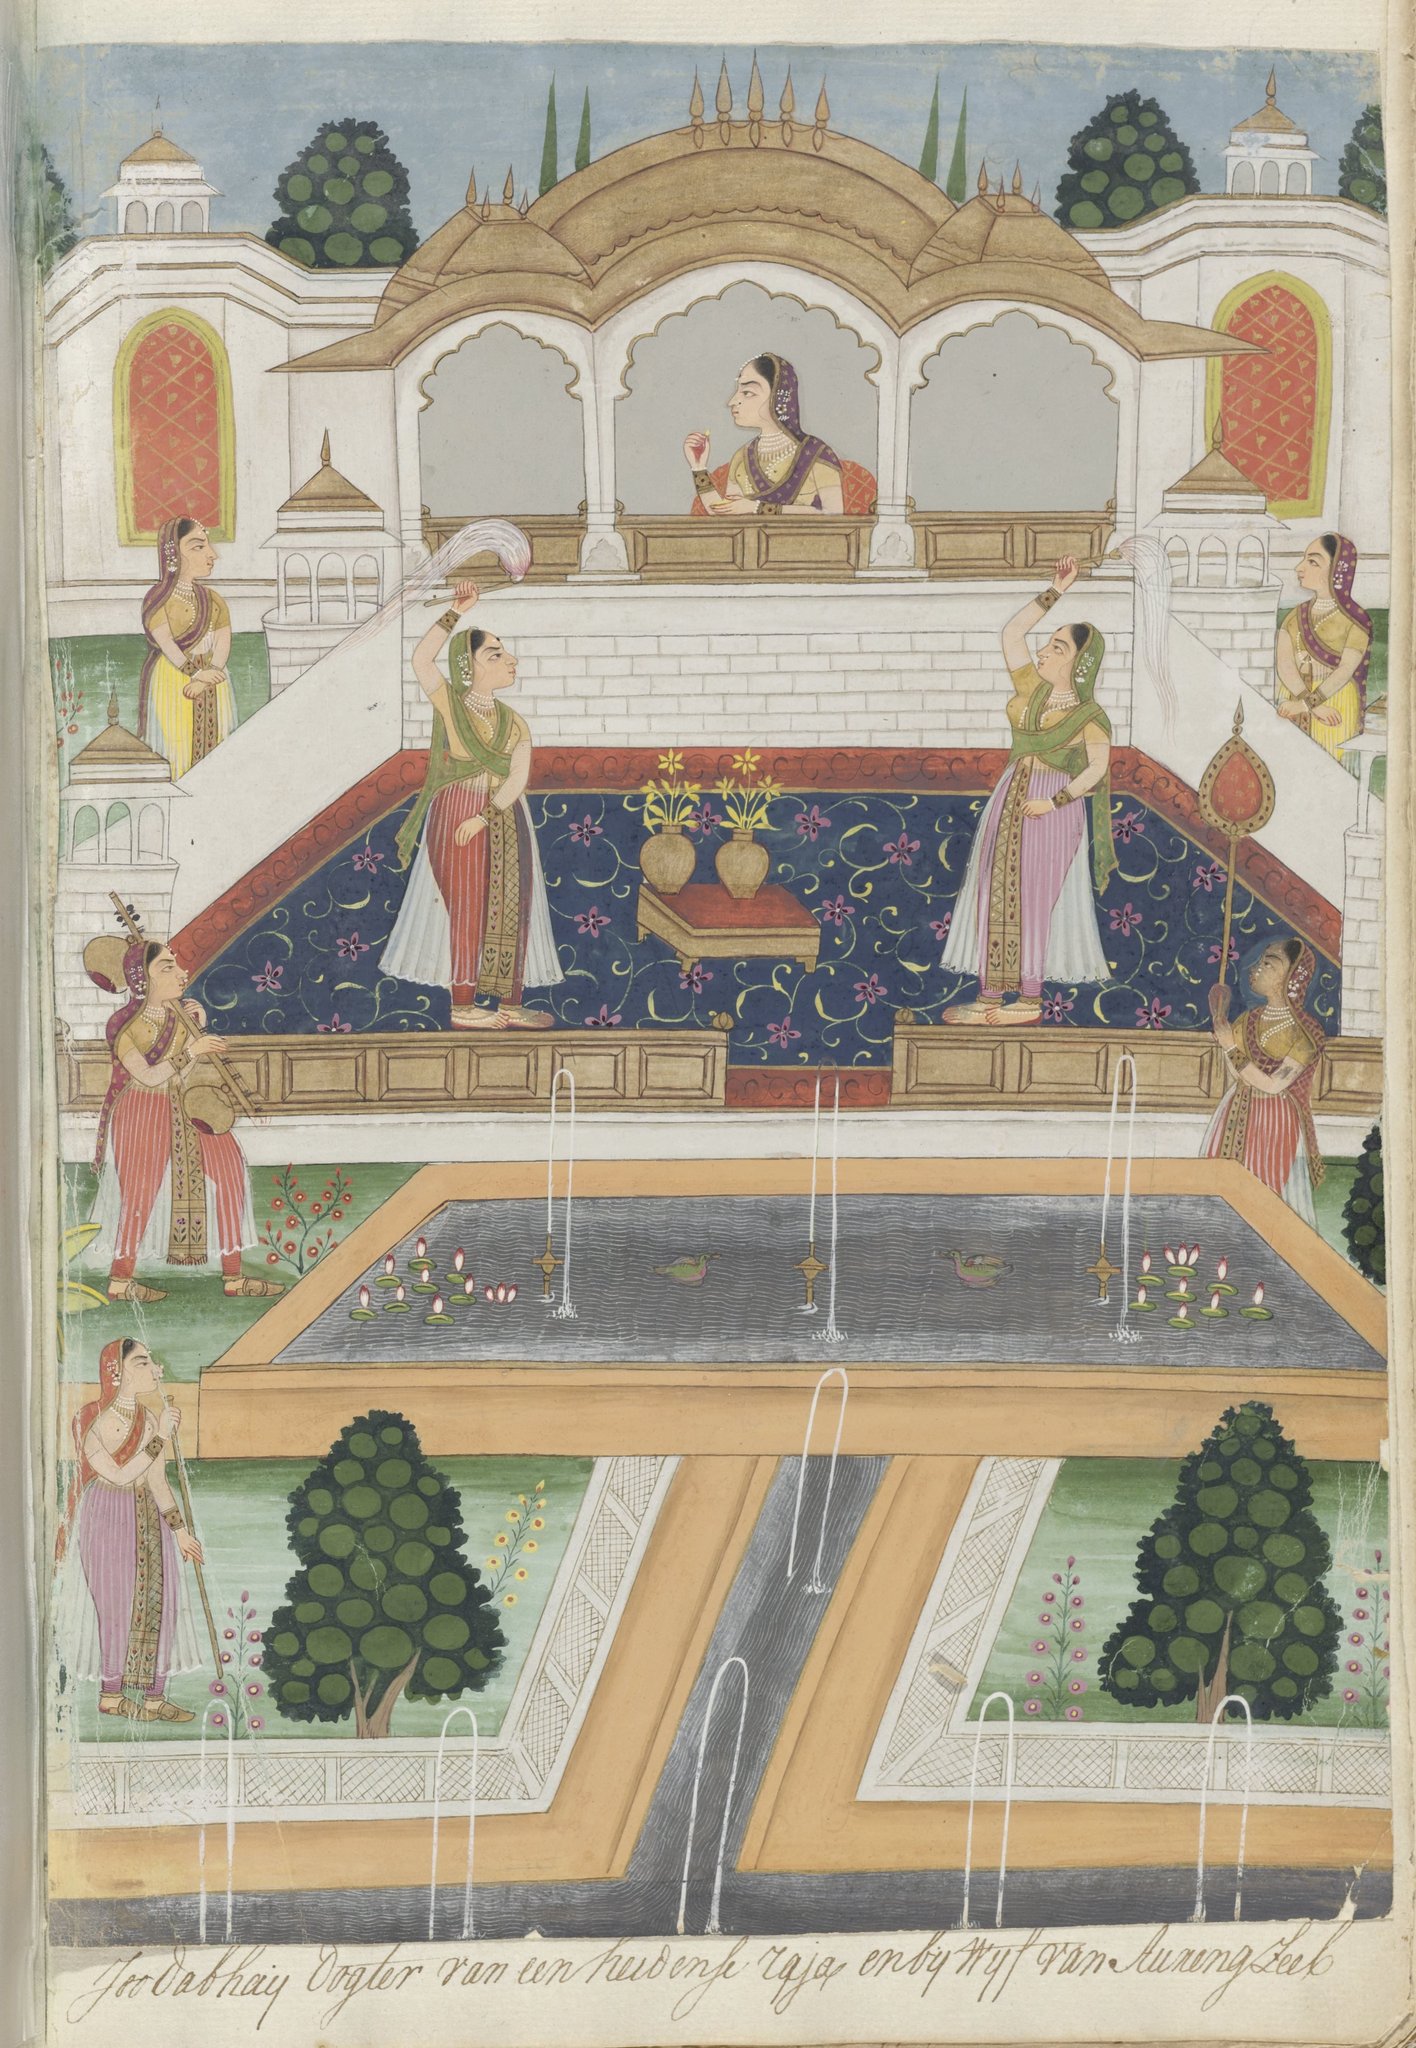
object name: drawing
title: Joodabhay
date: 1675-1725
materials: paper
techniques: drawing, writing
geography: deccan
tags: adrianus canter visscher, queen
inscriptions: caption: ‘Joodabhay dogter van een heidense raja en bij wijf van Auneng Zeeb’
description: Tekening uit het manuscript van de VOC dienaar Adrianus Canter Visscher met achterin achtentwintig Indiase miniaturen en twee kaarten van plaatsen aan de Coromandelkust. De tekst bestaat uit twee delen: een geschiedenis van het Mogolrijk en de VOC-vestigingen aan de Coromandelkust; daarna volgt een advies aan de Heren XVII over de economische situatie van de VOC in de Coromandel.